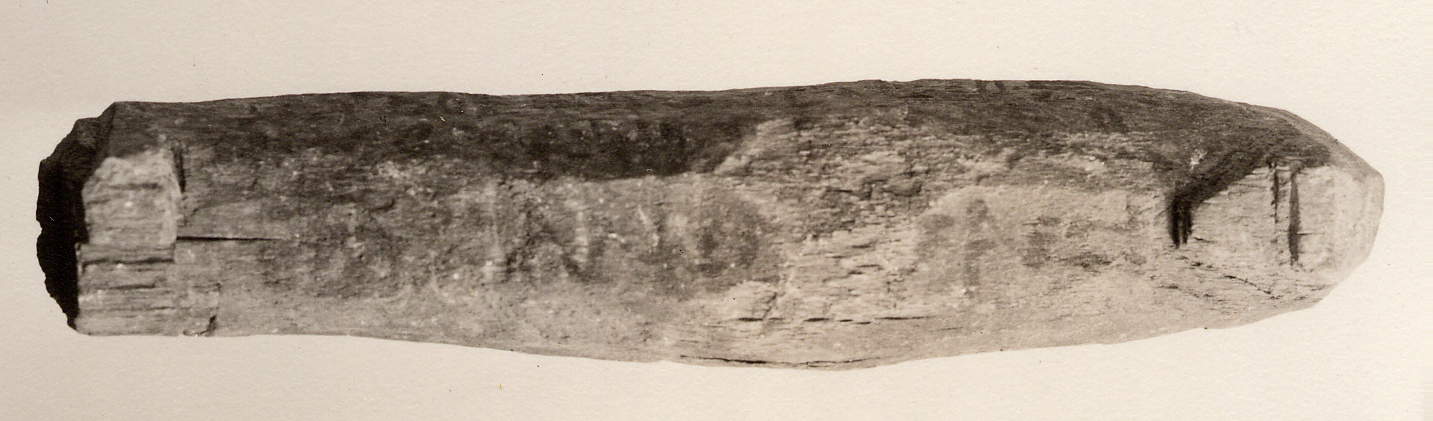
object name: shabti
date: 1640-1504 BCE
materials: wood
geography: egypt